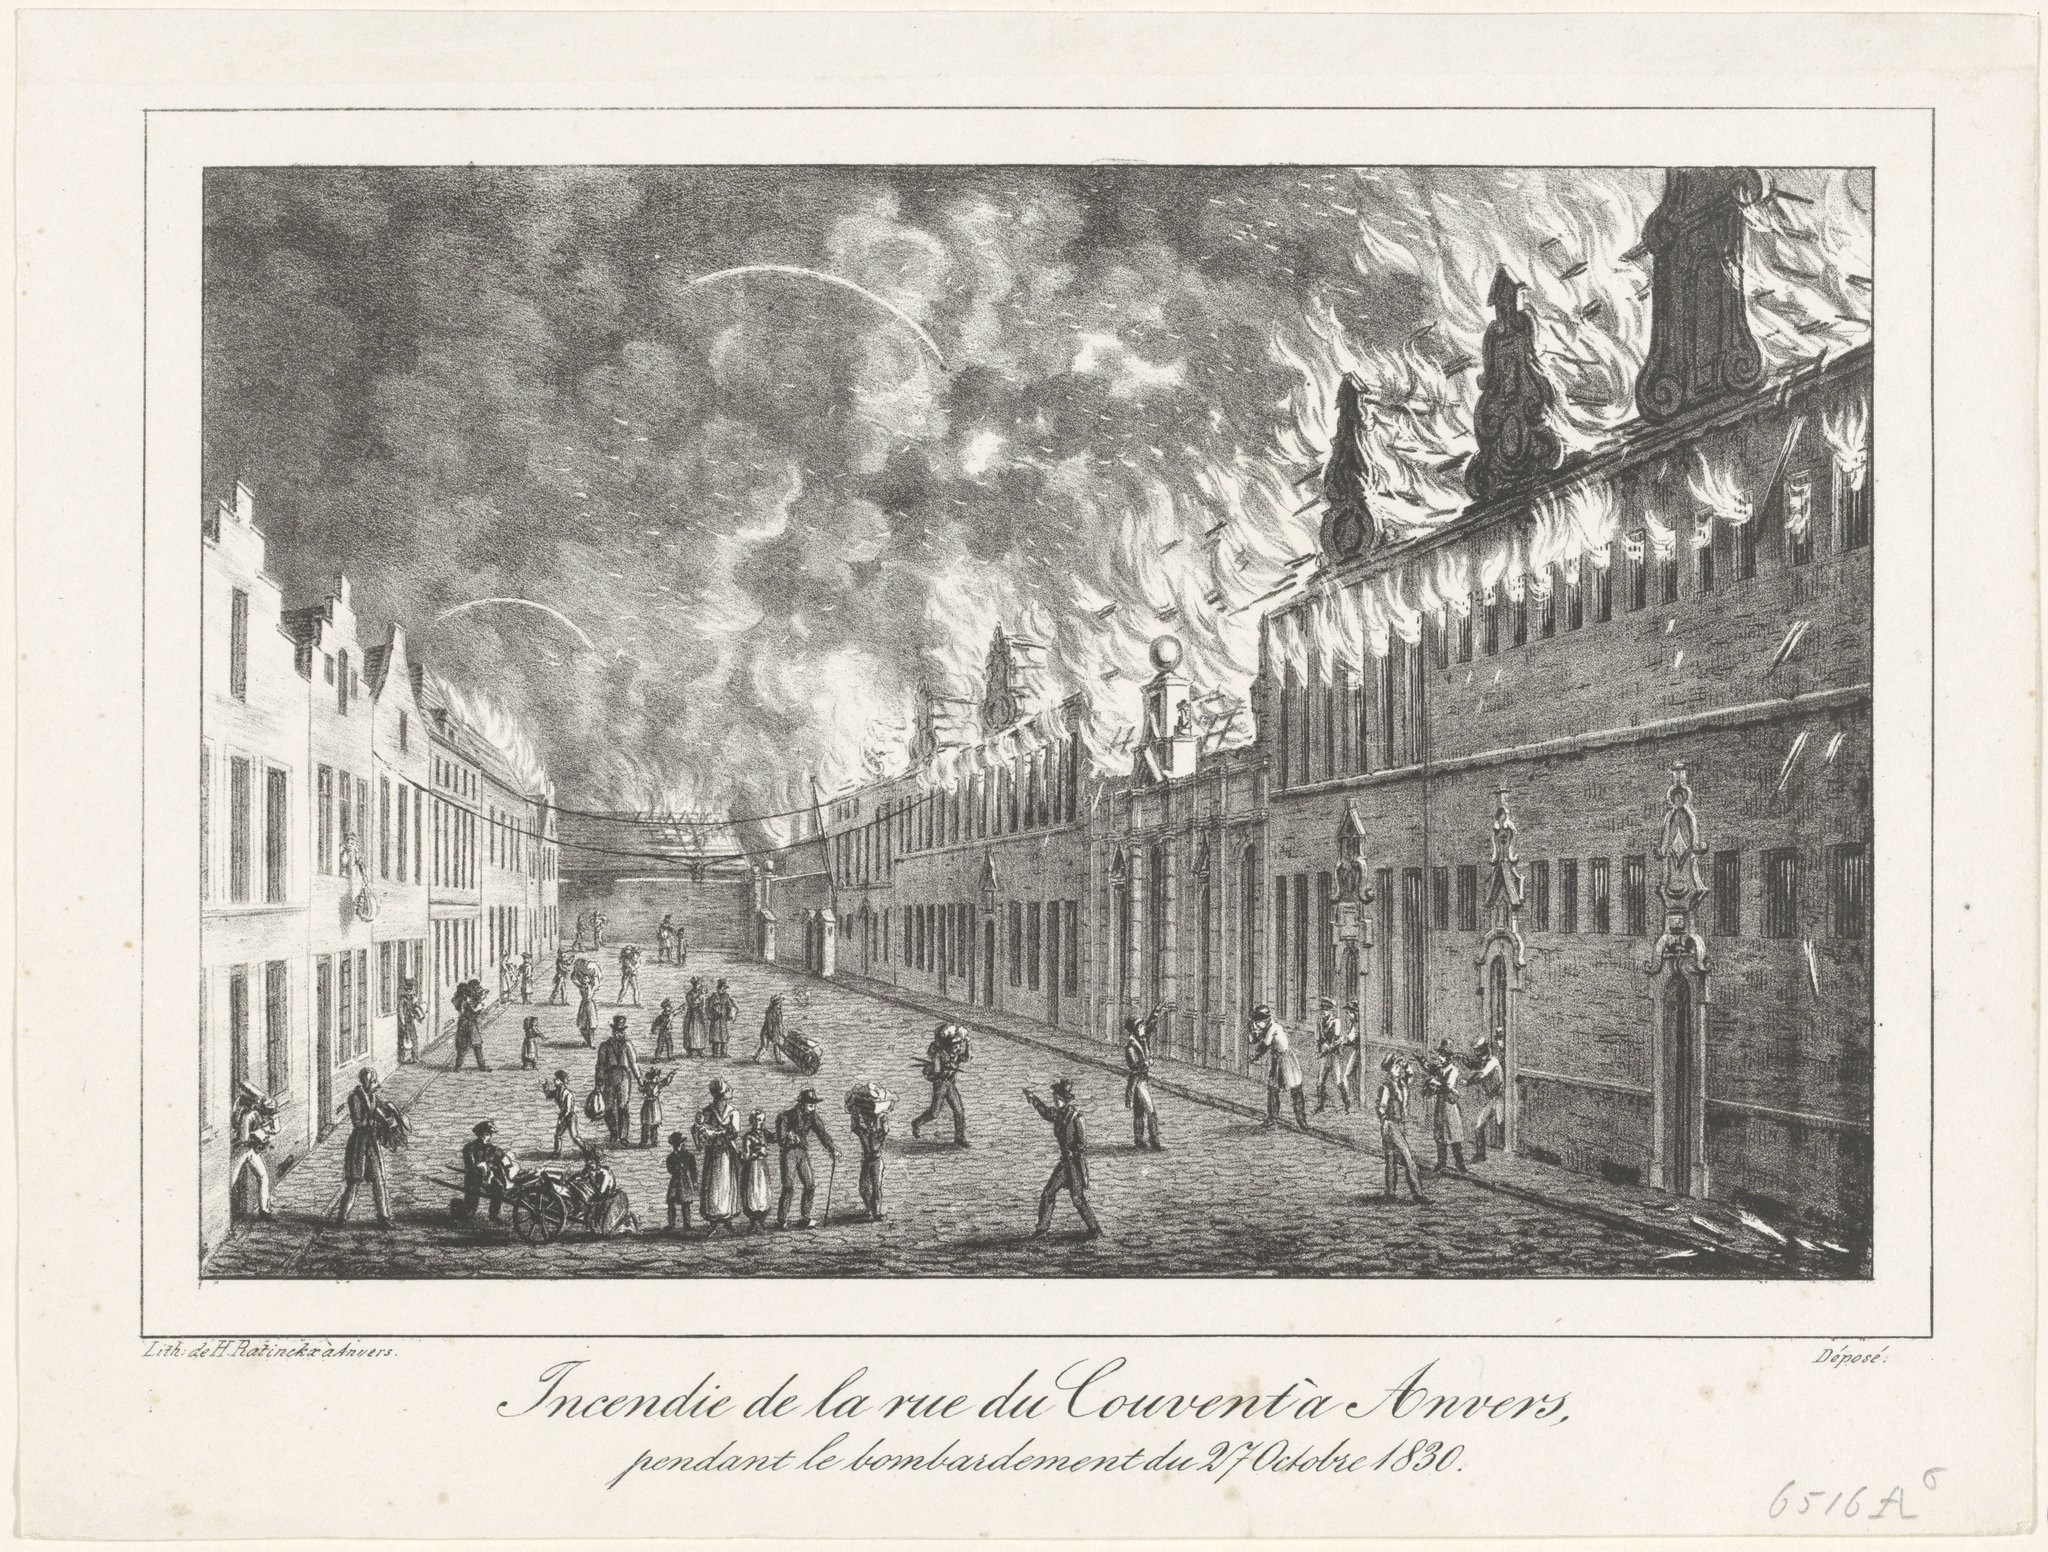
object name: print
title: Brand in de Kloosterstraat, 1830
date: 1830-1831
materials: paper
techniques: lithograph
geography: antwerp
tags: bombardment ~ siege, bombardment, antwerp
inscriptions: collector's mark: Lugt 2228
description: Onder FMH 6516 beschrijft Muller een serie van acht platen over de gebeurtenissen te Antwerpen van 26-27 oktober 1830, gedrukt bij Ratinckx te Antwerpen. In het Supplement worden onder het nummer 6516A nog eens negen platen vermeld die waarschijnlijk tot dezelfde serie behoren. Daarnaast bezit het RPK nog twee platen die waarschijnlijk tot dezelfde reeks behoren. Hier worden deze negentien platen beschreven als deel uit makend van één en dezelfde serie.